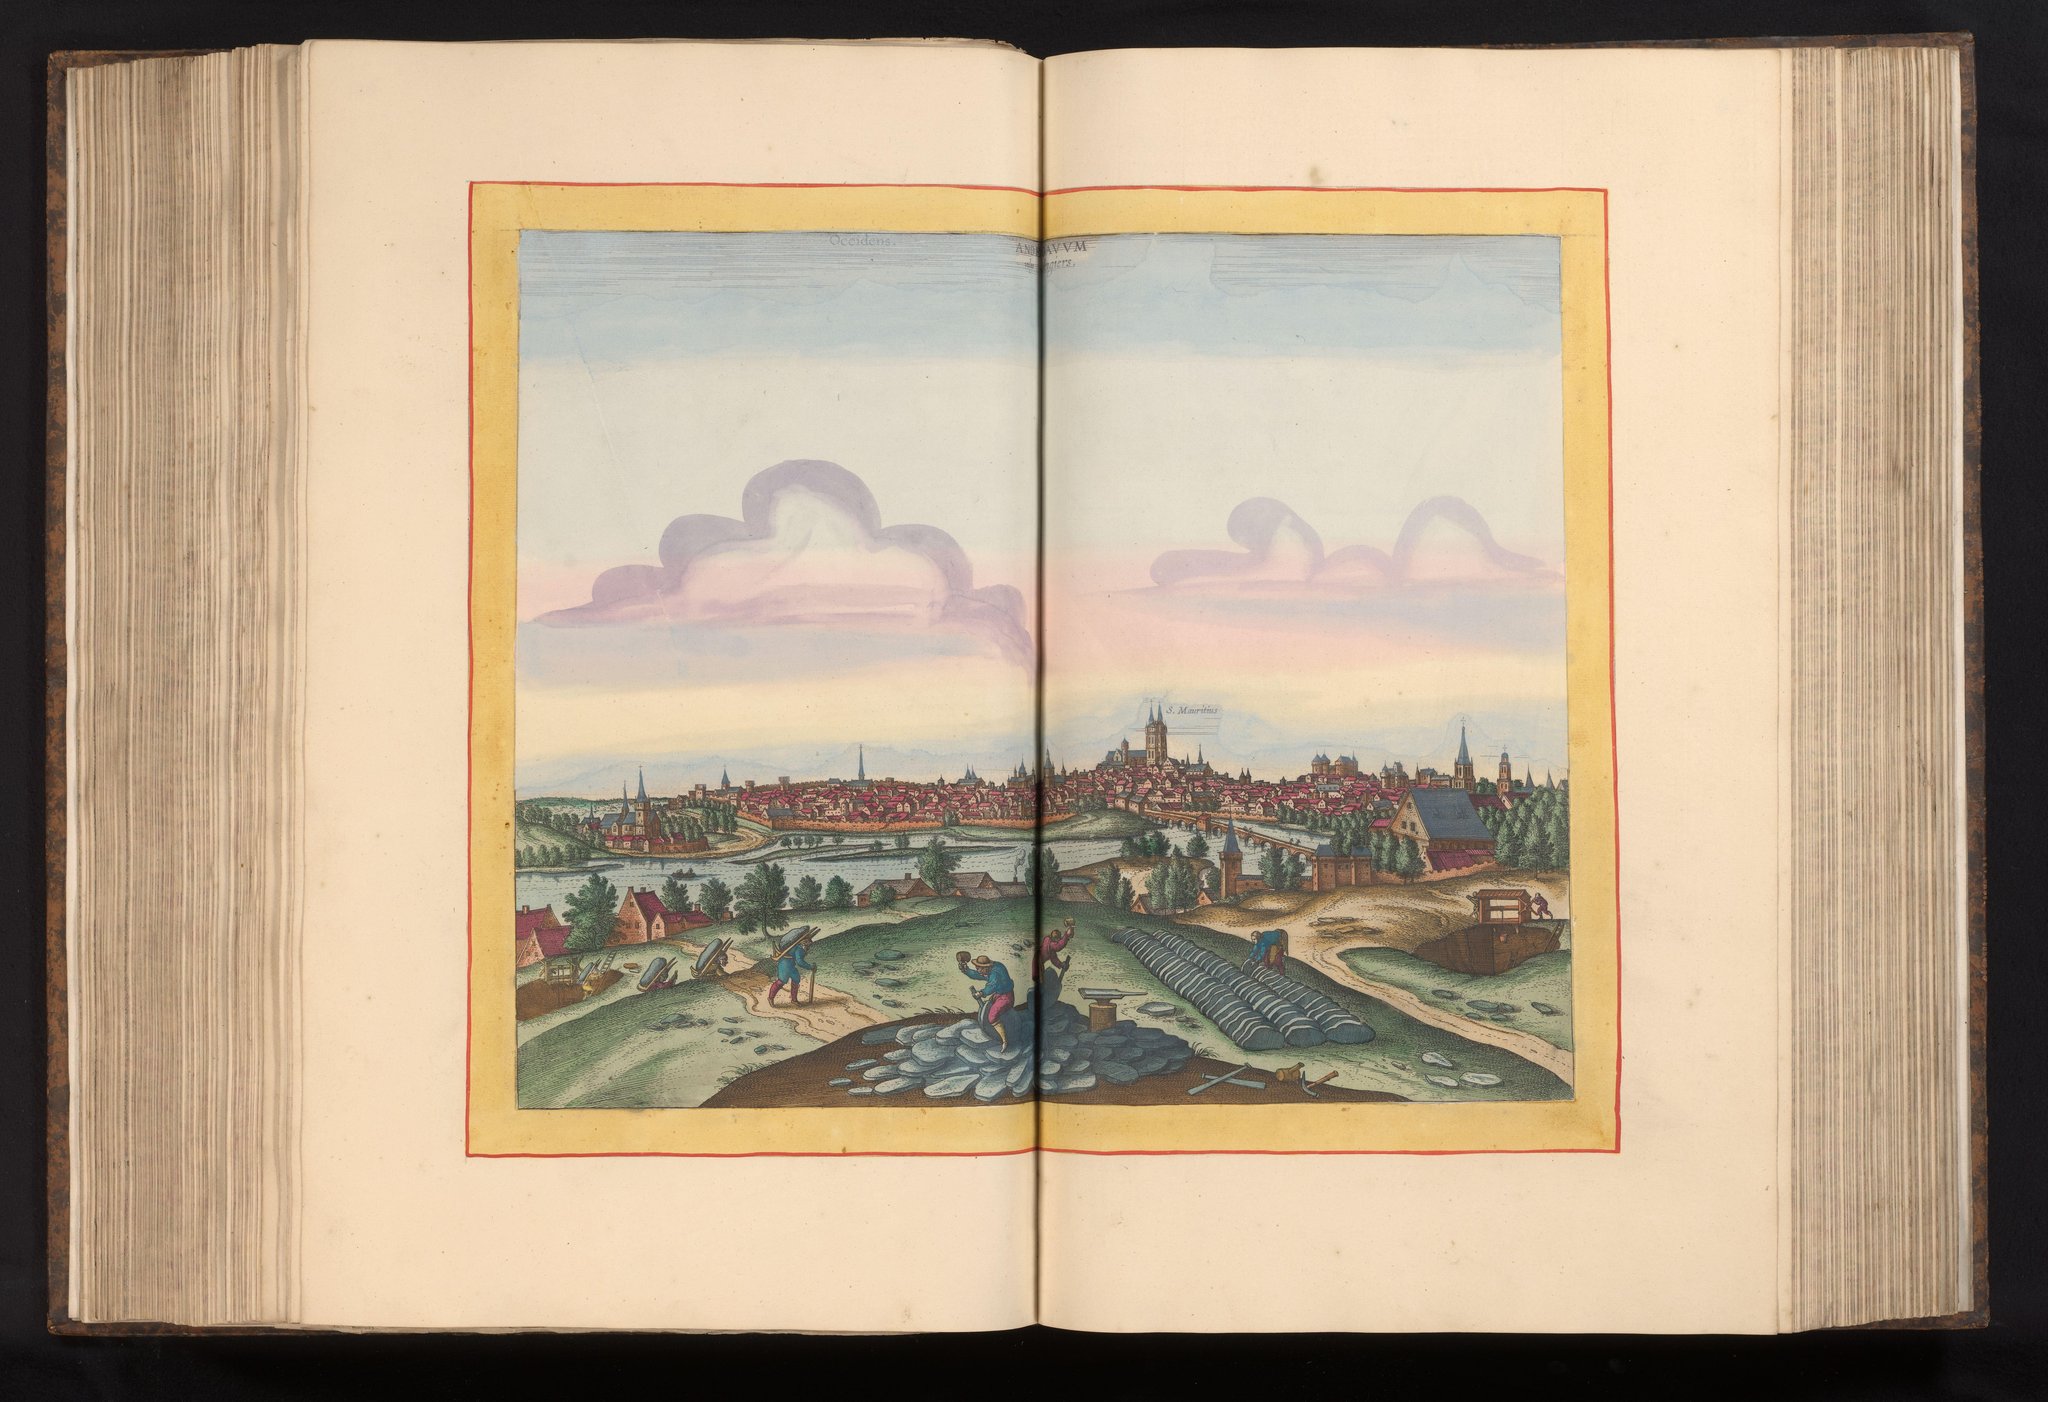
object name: print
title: Gezicht op Angers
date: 1561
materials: paper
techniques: engraving, hand coloring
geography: the hague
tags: city-view in general; 'veduta'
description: Deze prent is in meerdere atlassen gebruikt. Onder andere in verschillende edities van: Braun, Georg & Frans Hogenberg. Civitates orbis terrarum, en in: Theatrum exhibens celebriores Galliae et Helvetae urbes. Amsterdam: Johannes Janssonius, 1657, en in: Tooneel der vermaarste koop-steden. Amsterdam: Erven Johannes Janssonius van Waesberge, 1682. Origineel op één blad gedrukt met het gezicht op Tours (RP-P-1956-255).